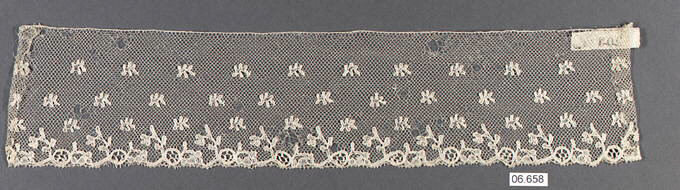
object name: fragment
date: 1767-1800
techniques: lace